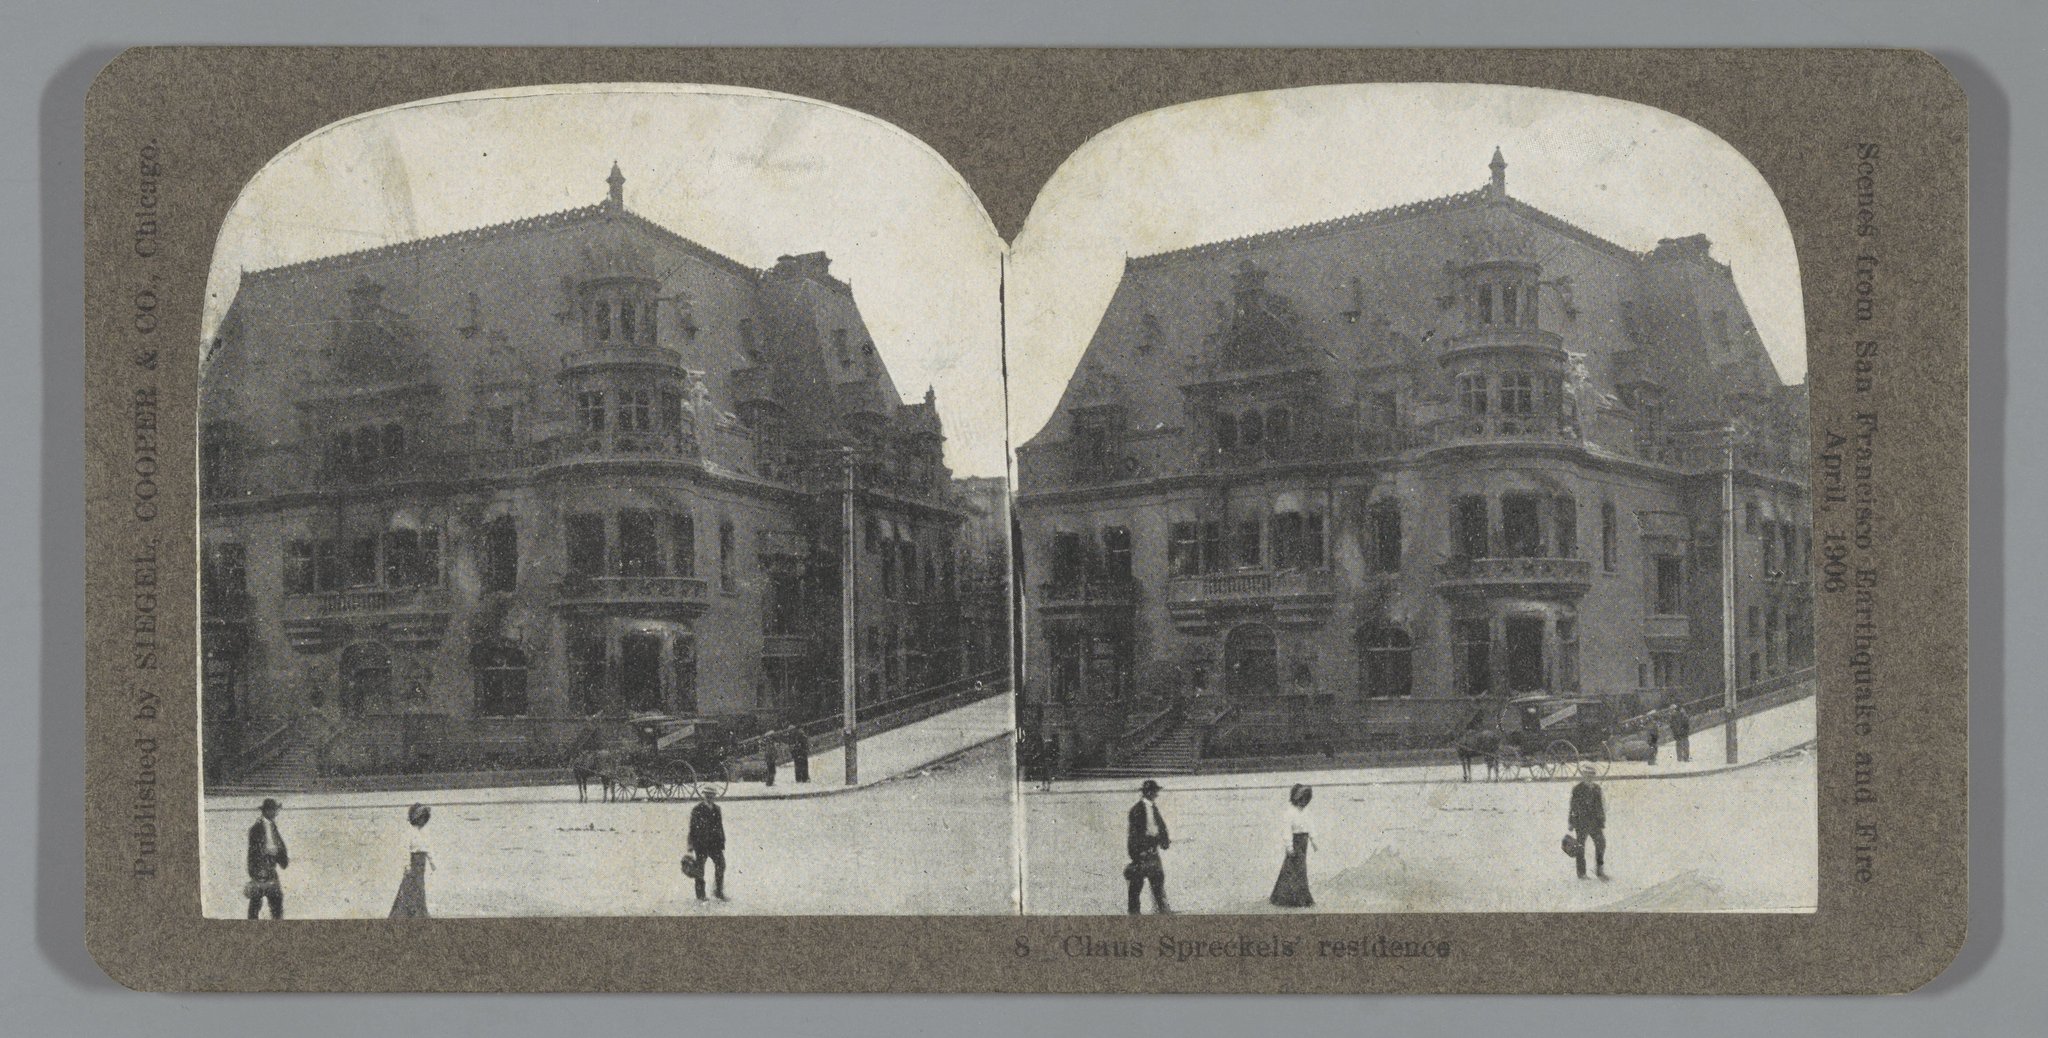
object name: photomechanical print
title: Beschadigd woonhuis van Claus Spreckels na de aardbeving in San Francisco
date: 1906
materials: cardboard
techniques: autotype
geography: san francisco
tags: façade (of house or building)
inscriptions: number: ‘8’, copyright notice: ‘COPYRIGHT BY TOM M. PHILLIPS/ 1906’